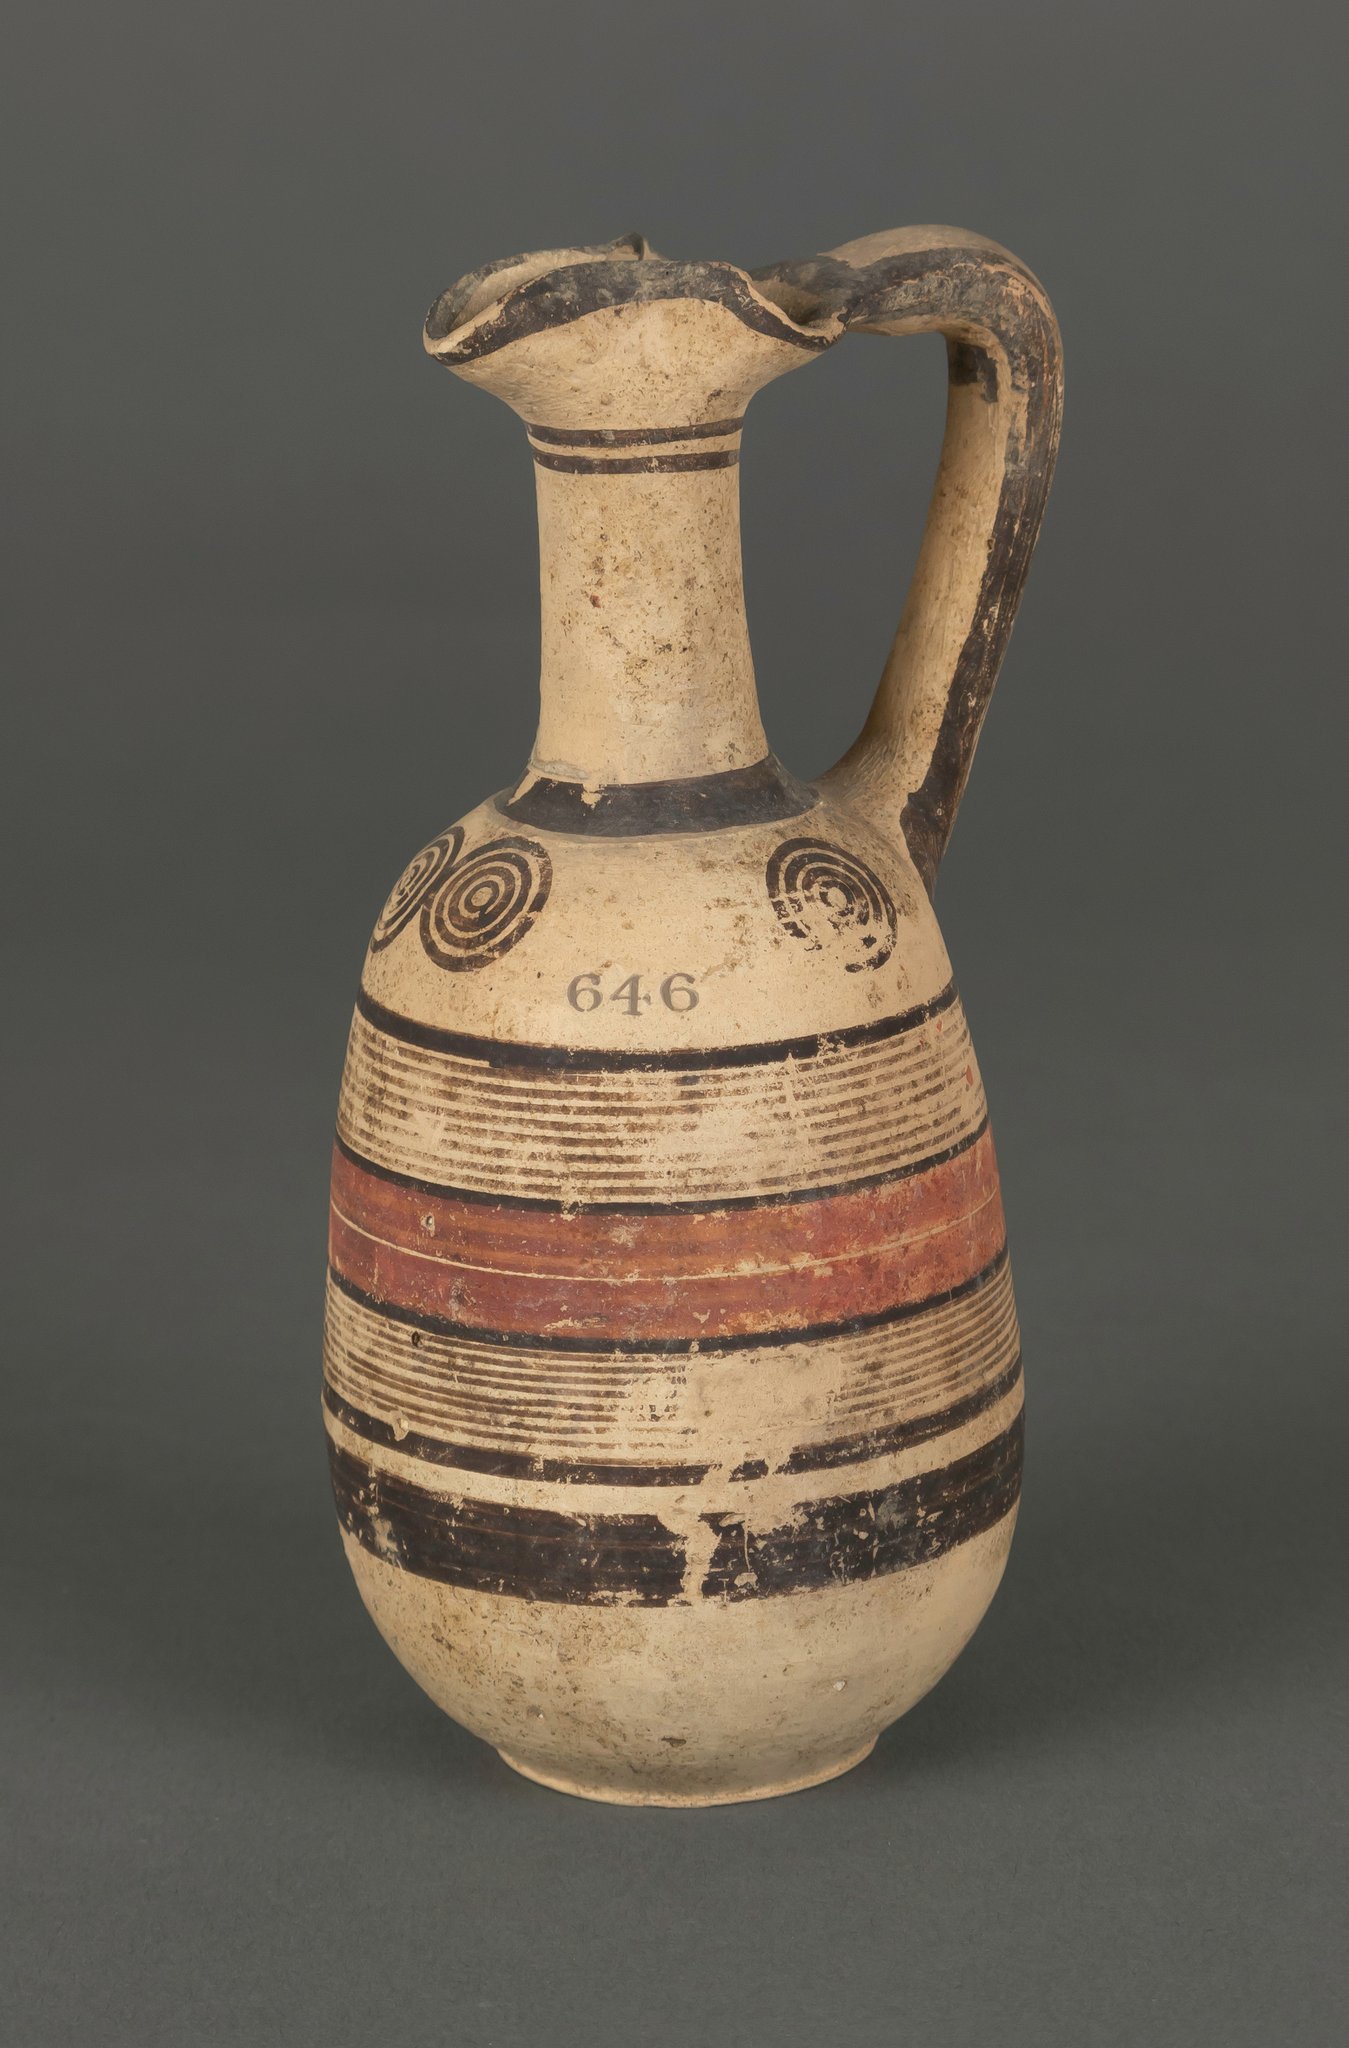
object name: jug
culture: cypriot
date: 600-480 BCE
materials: terracotta